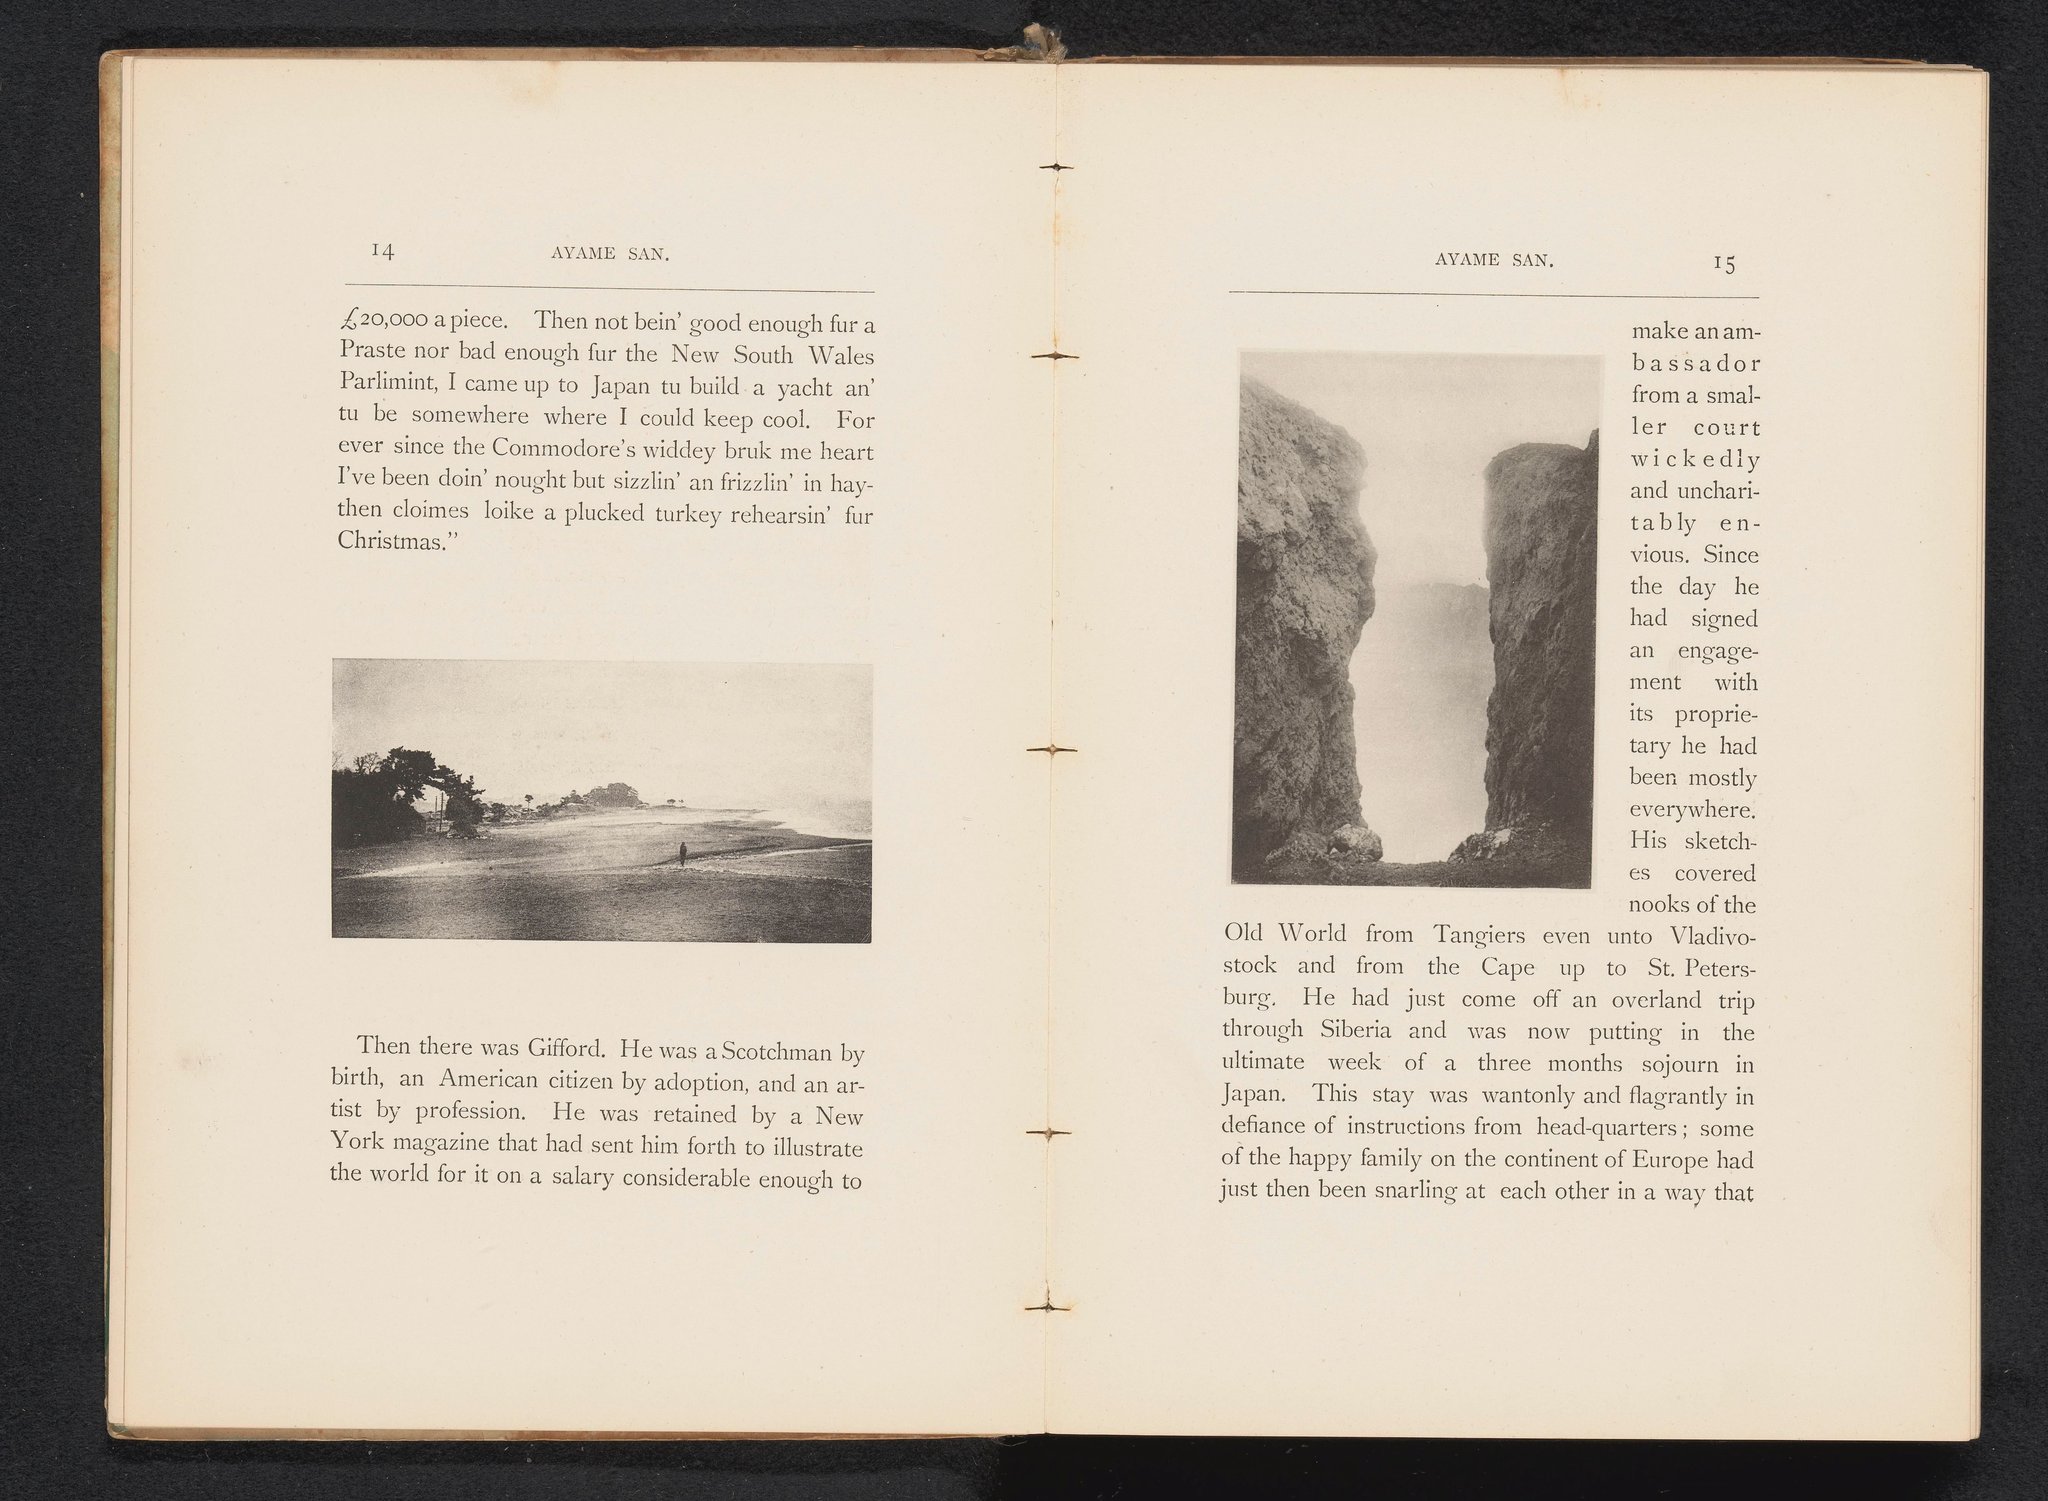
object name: photomechanical print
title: Kloof te Japan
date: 1882-1892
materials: paper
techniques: photograph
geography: japan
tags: ravine, chasm, abyss, canyon